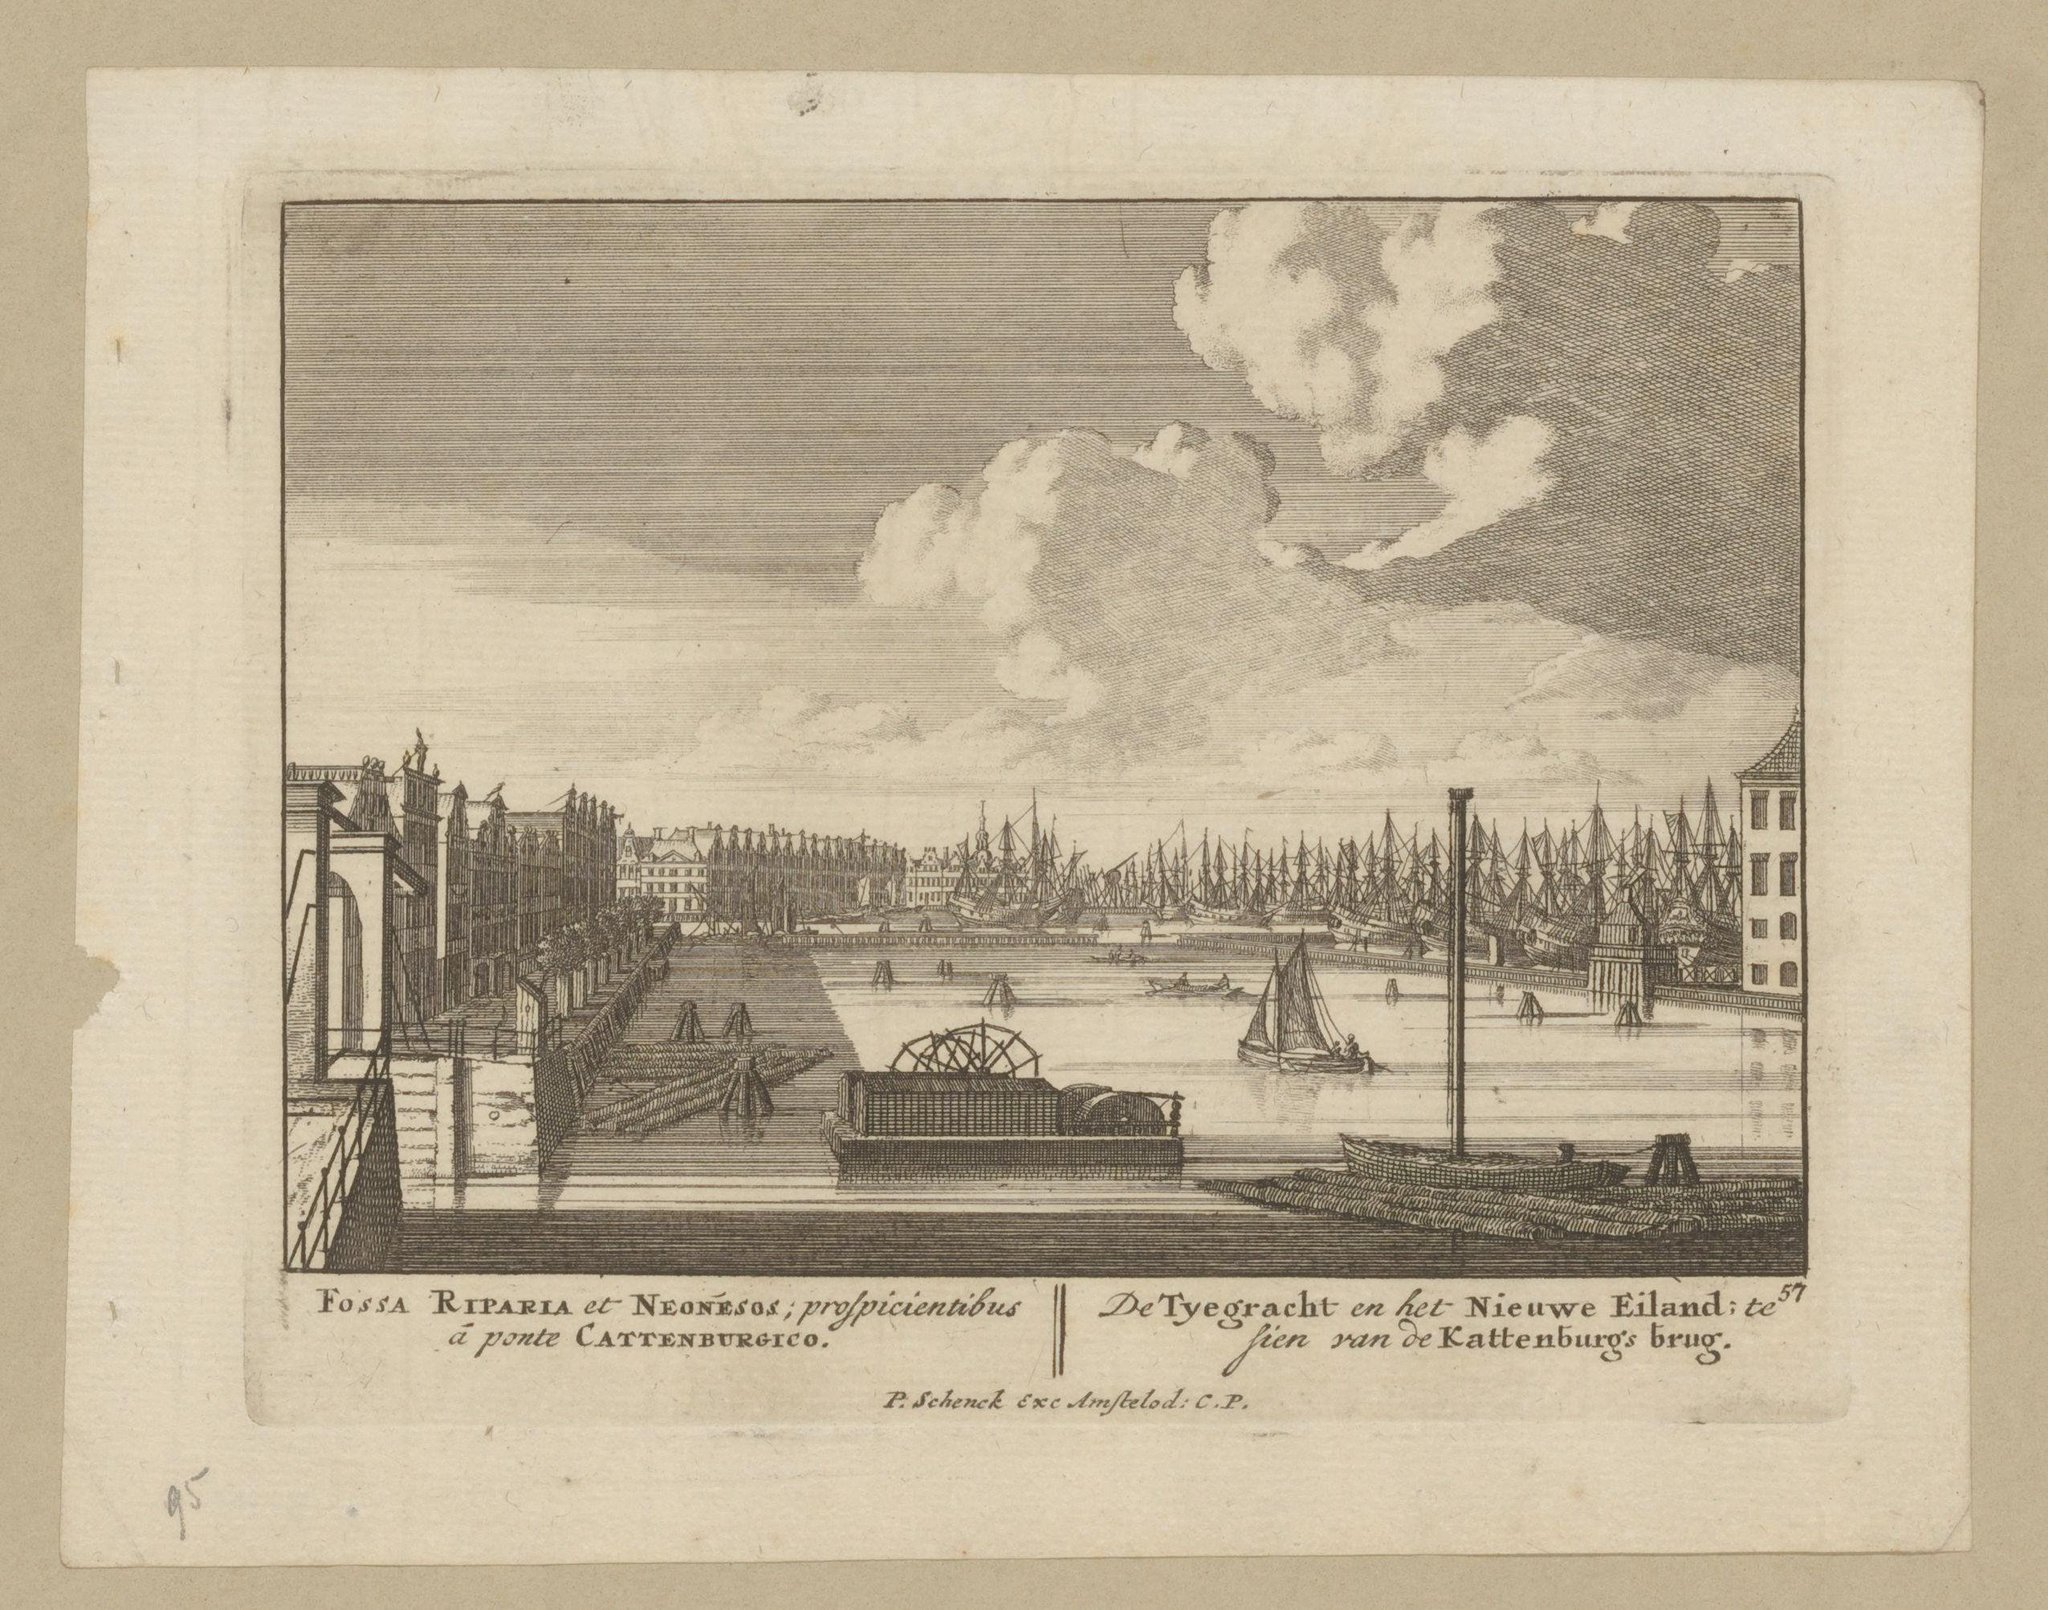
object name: print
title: Gezicht op de Prins Hendrikkade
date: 1694-1697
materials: paper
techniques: etching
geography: amsterdam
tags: sailing-ship, sailing-boat, city-view in general; 'veduta', river, bridge in city across river, canal, etc., street, boat propelled by man or animal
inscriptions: collector's mark: ‘11.96AB’ Lugt 1641b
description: Prent gebruikt in: Call, Jan van. Admirandorum Quadruplex Spectaculum. Amsterdam: Pieter Schenk (I), 1700. De titelprent, opdracht en het portret van Frederik van Saksen zijn gegraveerd door Pieter Schenk (I). De overige prenten uit deze serie zijn, zoals aangegeven op de titelprent, van de hand van Jan van Call (I).